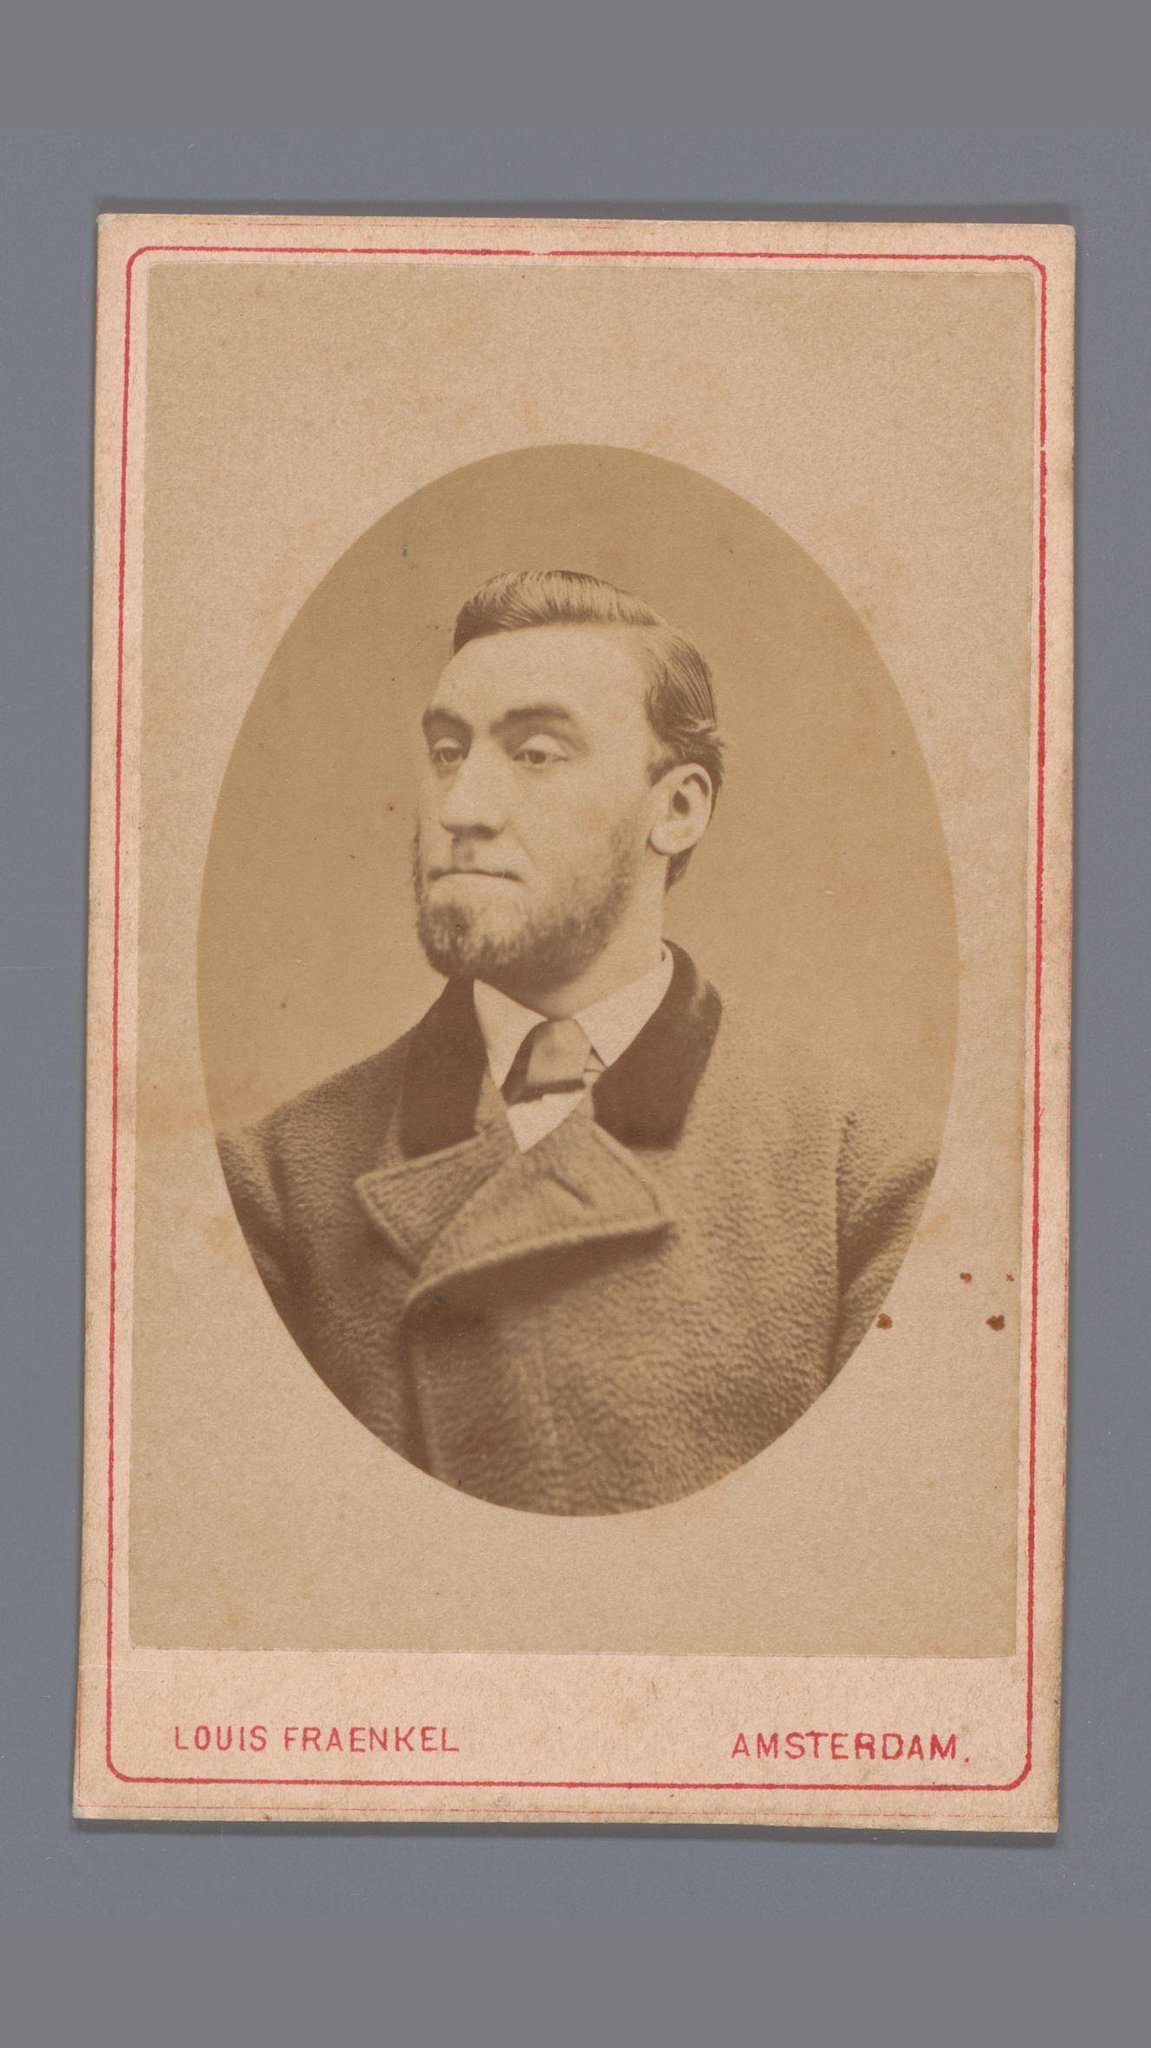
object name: photograph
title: Portret van een onbekende man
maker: louis fraenkel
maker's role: fotograaf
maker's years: 1842-1929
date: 1878-1886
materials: cardboard, paper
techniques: albumen print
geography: amsterdam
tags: adult man, anonymous historical person portrayed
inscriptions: inscription: ‘van deze portretten kan men steeds/ nabestellen tot verminderde Prijzen.’, address: ‘Leidsche Straat/ 70/ AMSTERDAM’